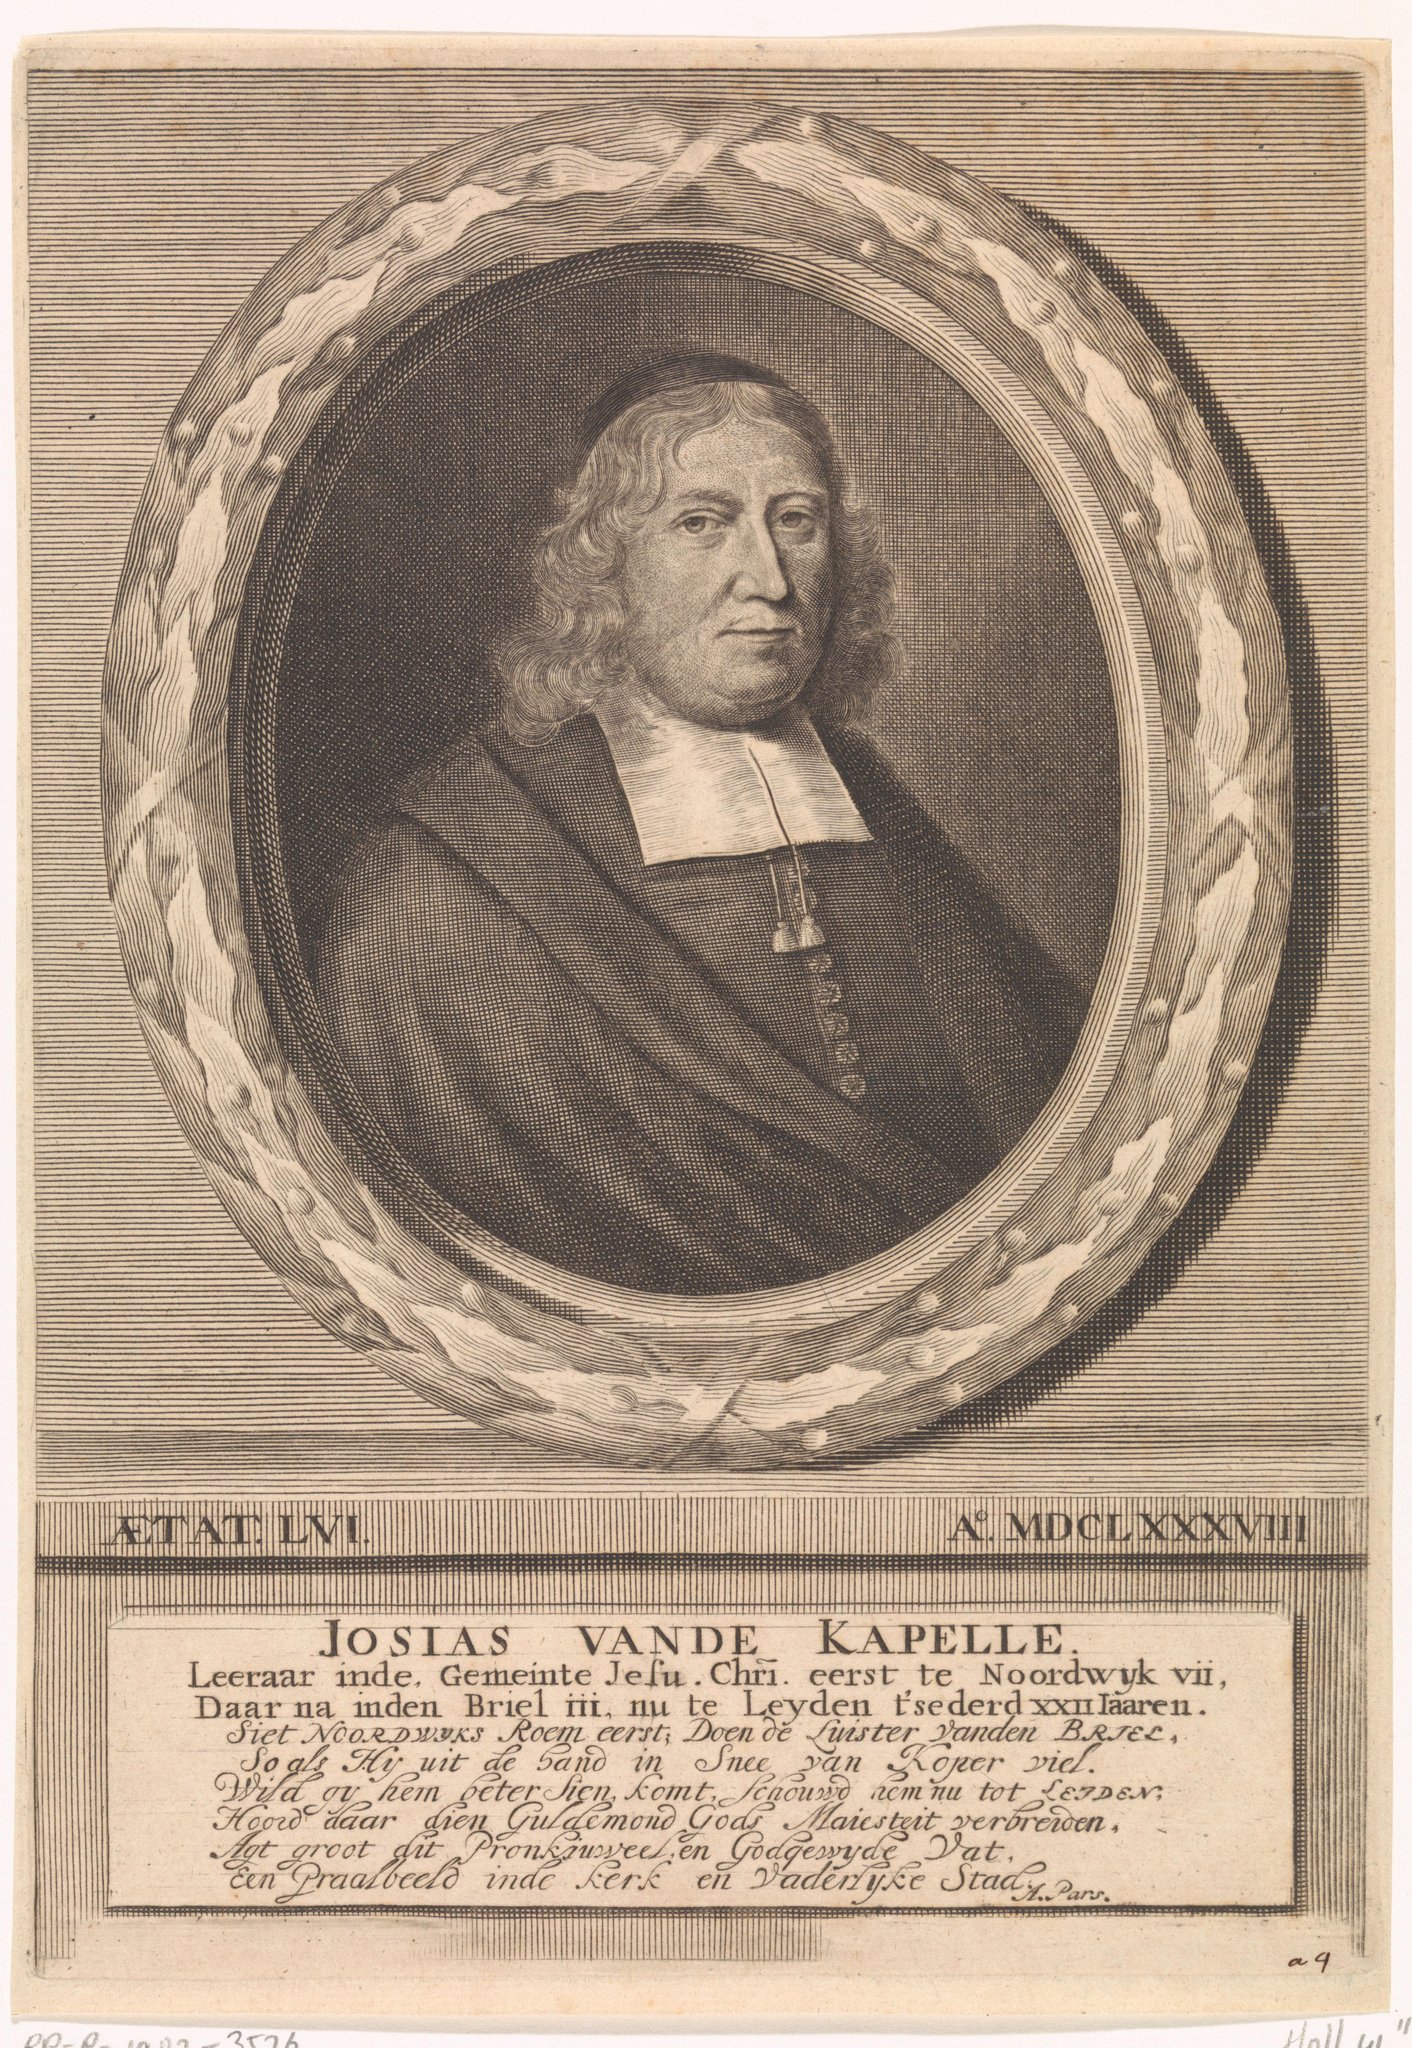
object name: print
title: Portret van Josias van der Kapelle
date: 1688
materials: paper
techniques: engraving, etching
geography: leiden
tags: predikant, josias van der kapelle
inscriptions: inscription: ‘a4’, collector's mark: Lugt 2228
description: Portret van Josias van der Kapelle, predikant te Leiden op 56-jarige leeftijd. Op de sokkel een zesregelig vers in het Nederlands.